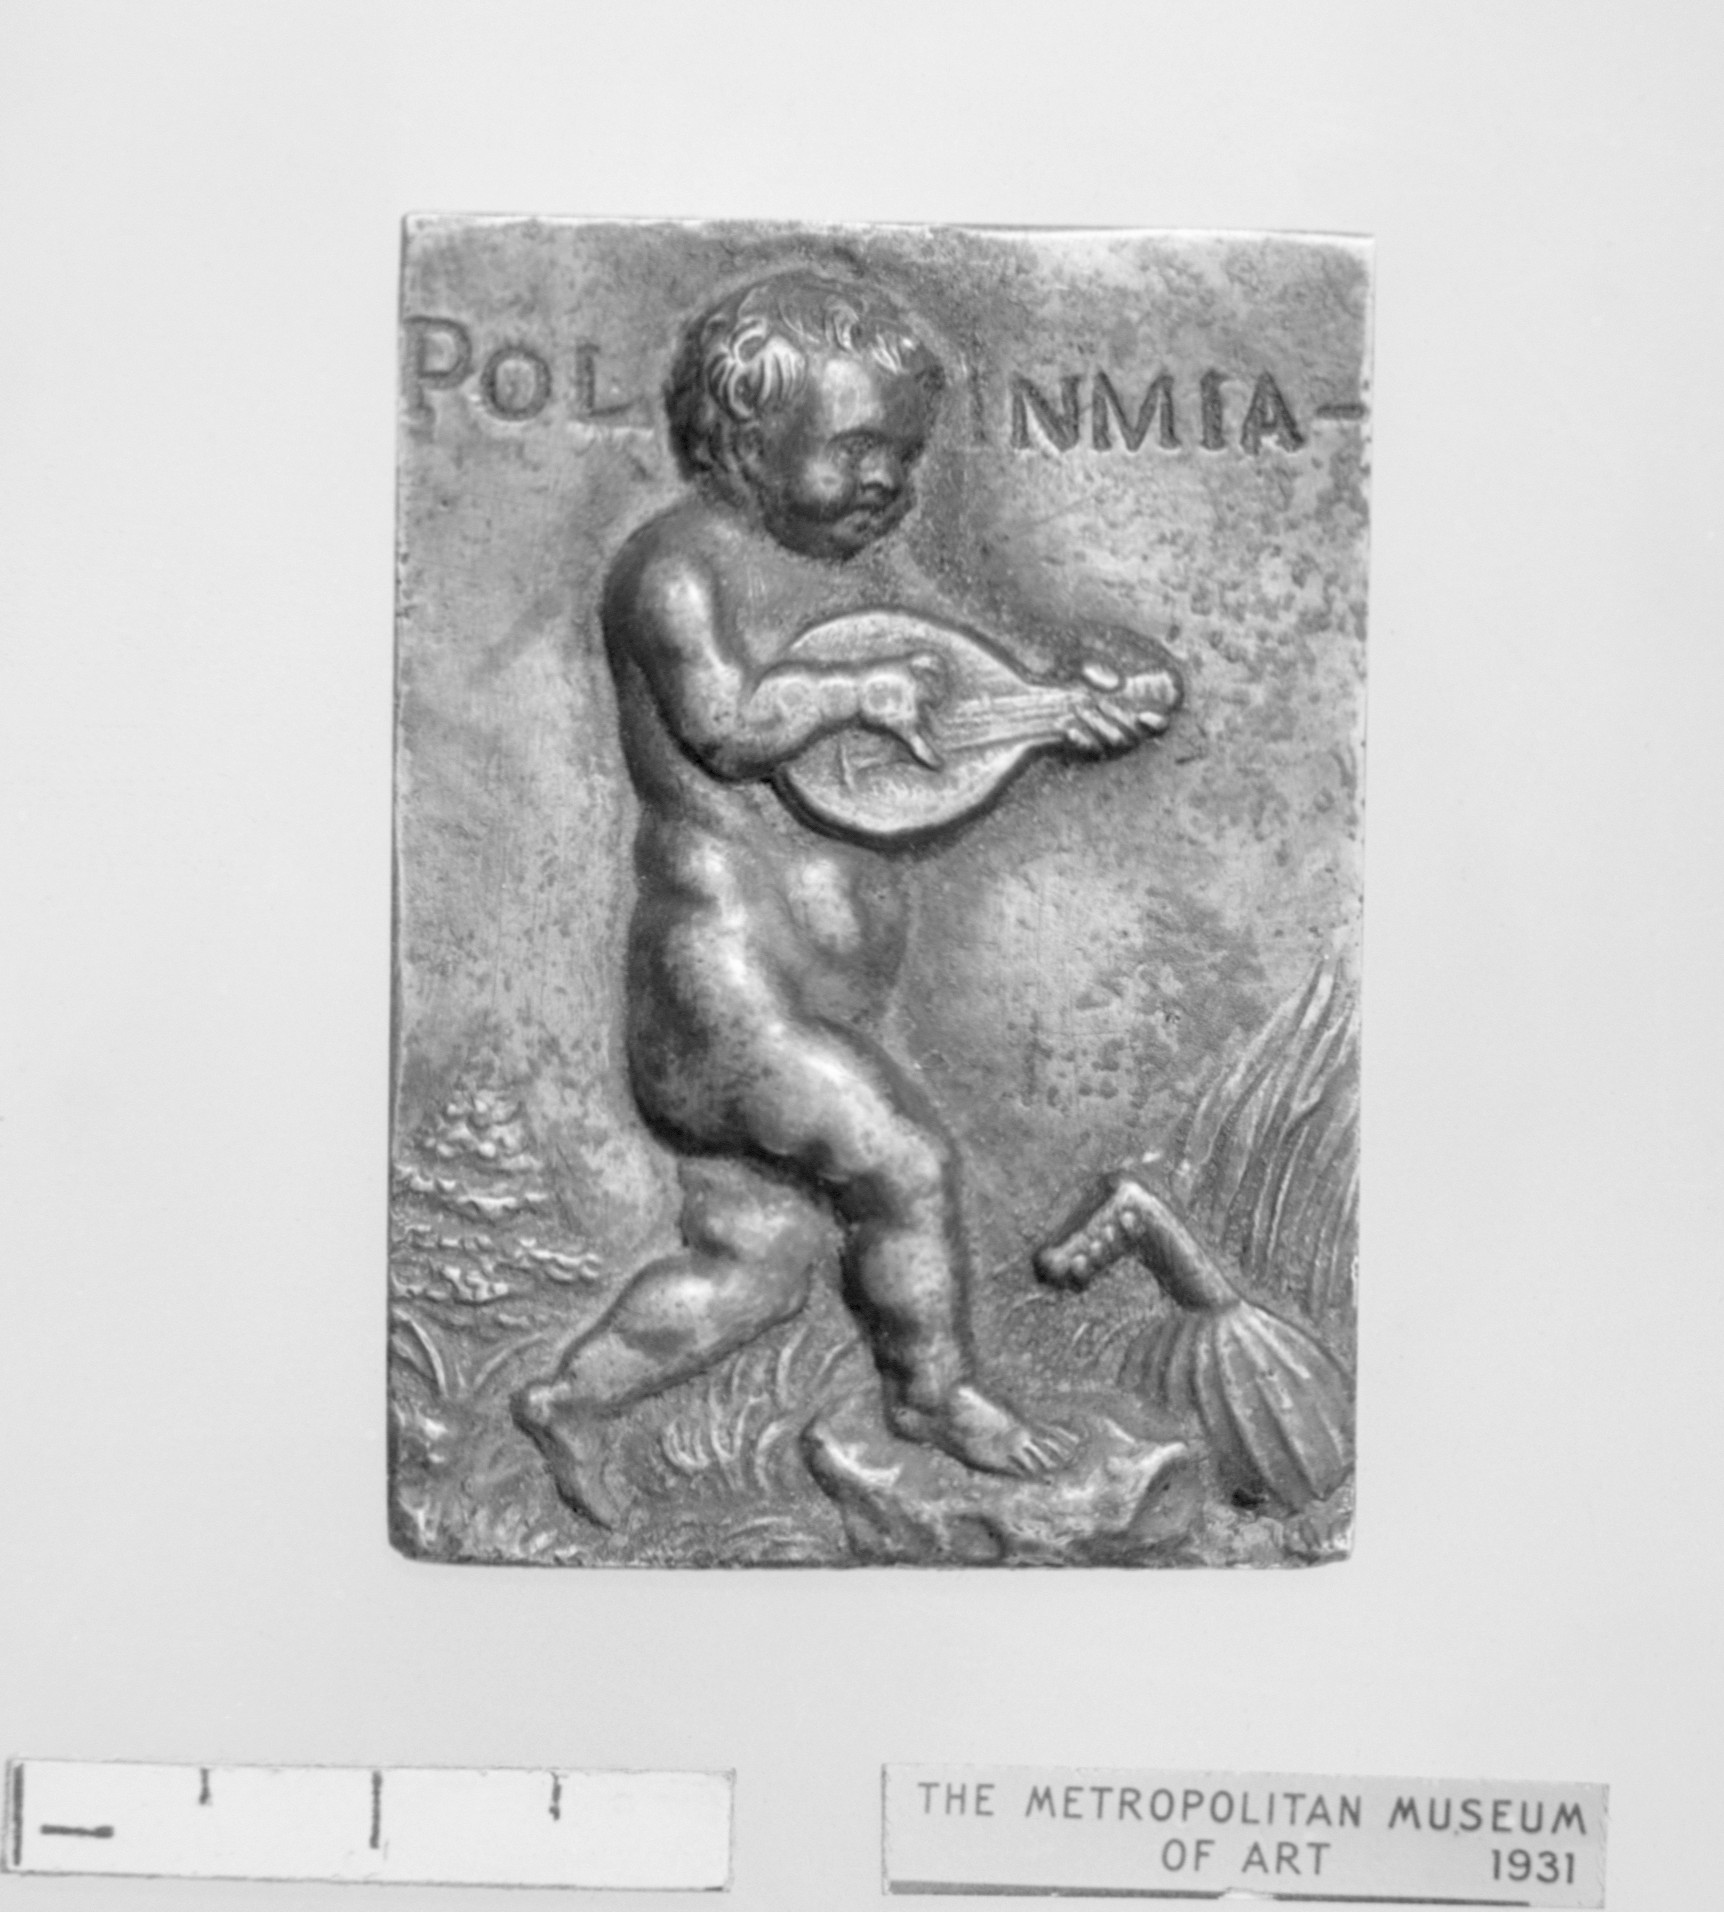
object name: plaquette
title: Putto with attributes of the Muse Polymnia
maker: peter flötner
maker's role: artist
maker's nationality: german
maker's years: 1485-1546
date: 1501-1600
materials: silver gilt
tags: musical instruments,putti